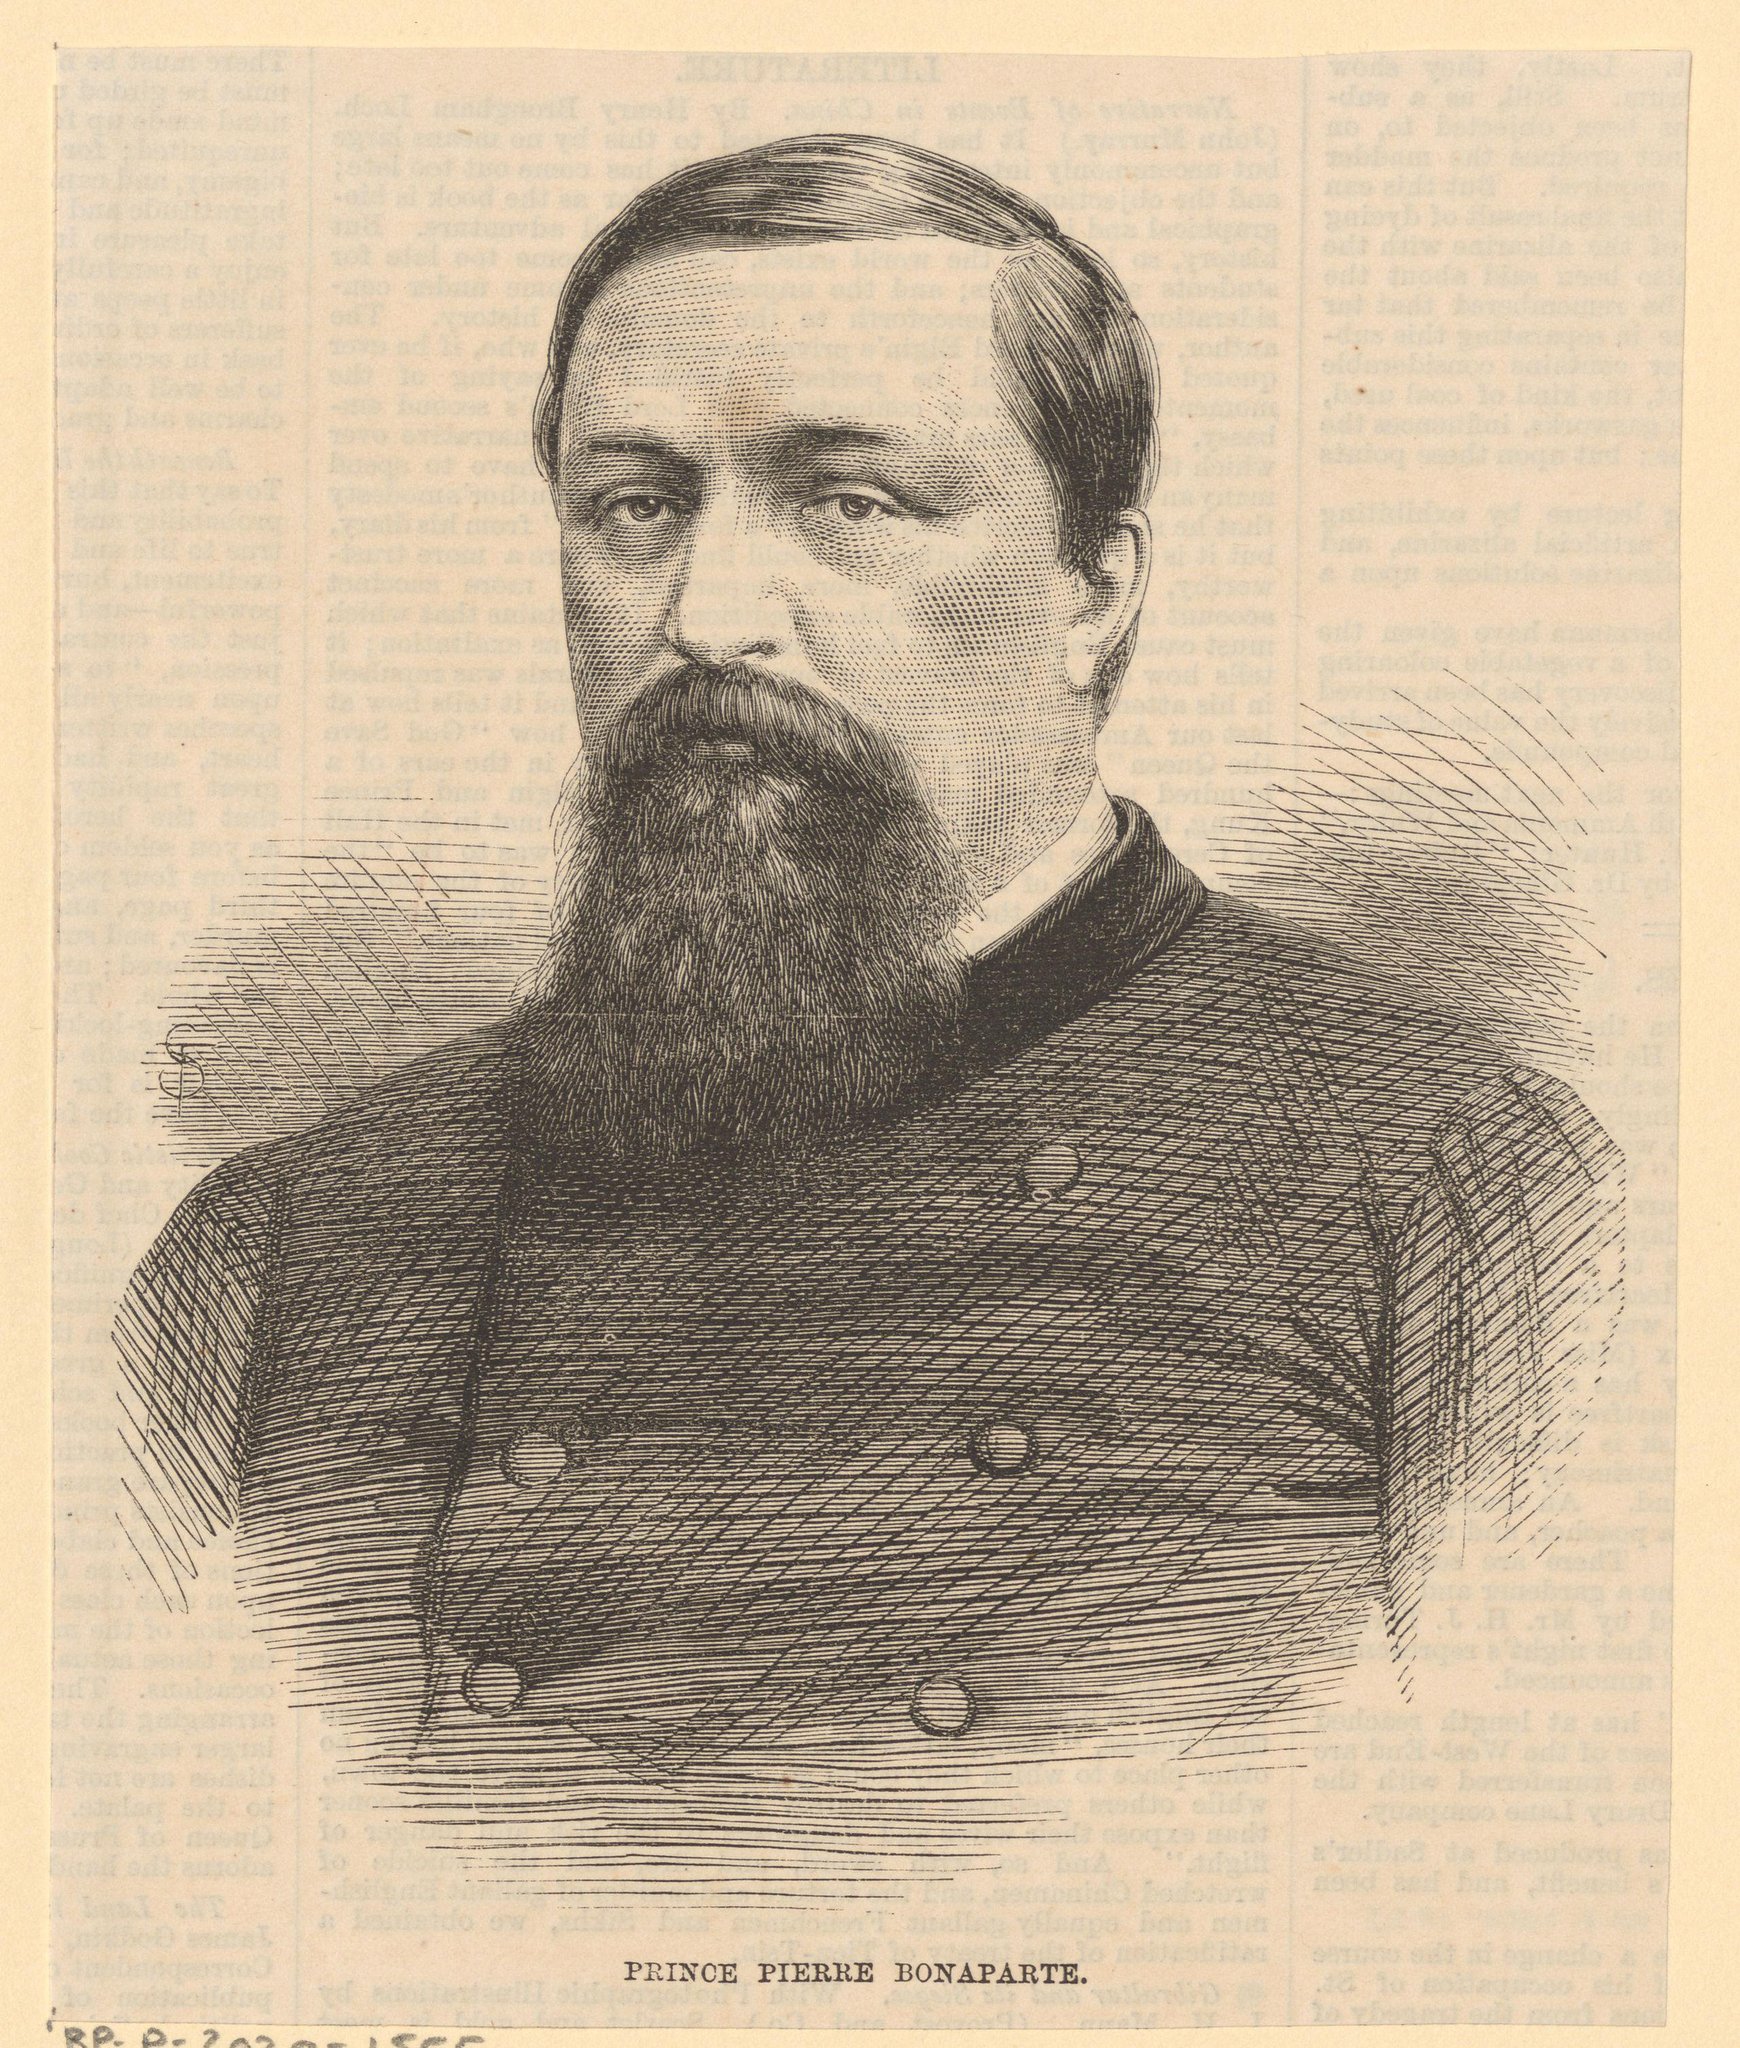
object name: print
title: Portret van Pierre-Napoleon Bonaparte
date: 1870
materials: paper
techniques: letterpress printing, engraving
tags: rome, politician, prince, historical persons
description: Prent uit: The Illustrated London News, 26 maart 1870.